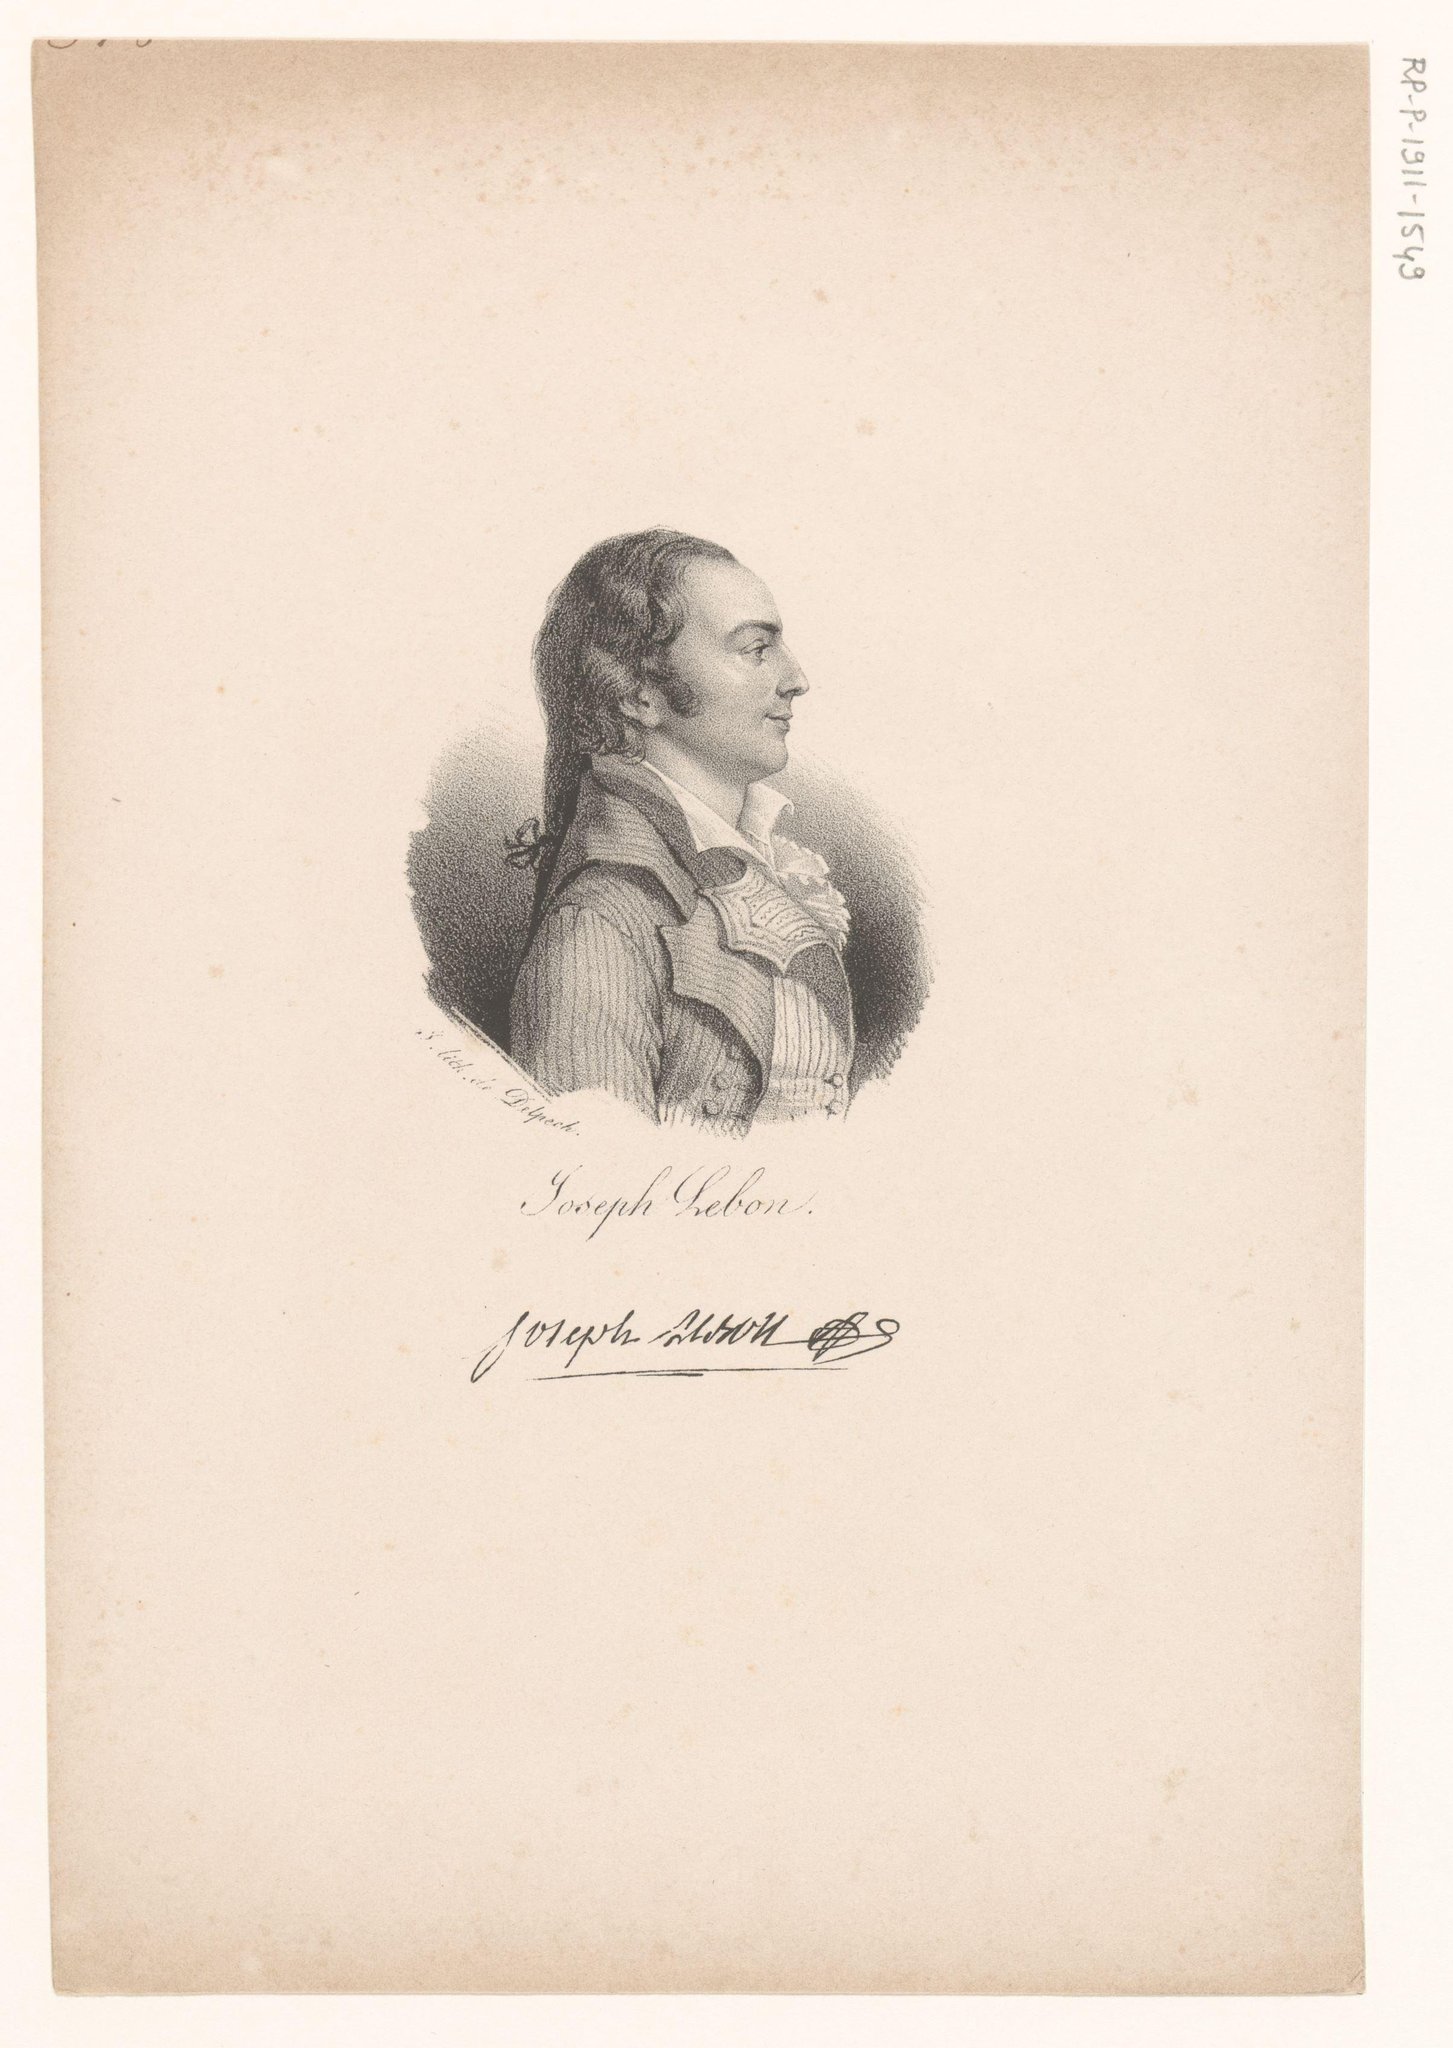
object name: print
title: Portret van Joseph Le Bon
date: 1818-1842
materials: paper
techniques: lithograph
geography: paris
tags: politician, historical persons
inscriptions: collector's mark: Lugt 2228a